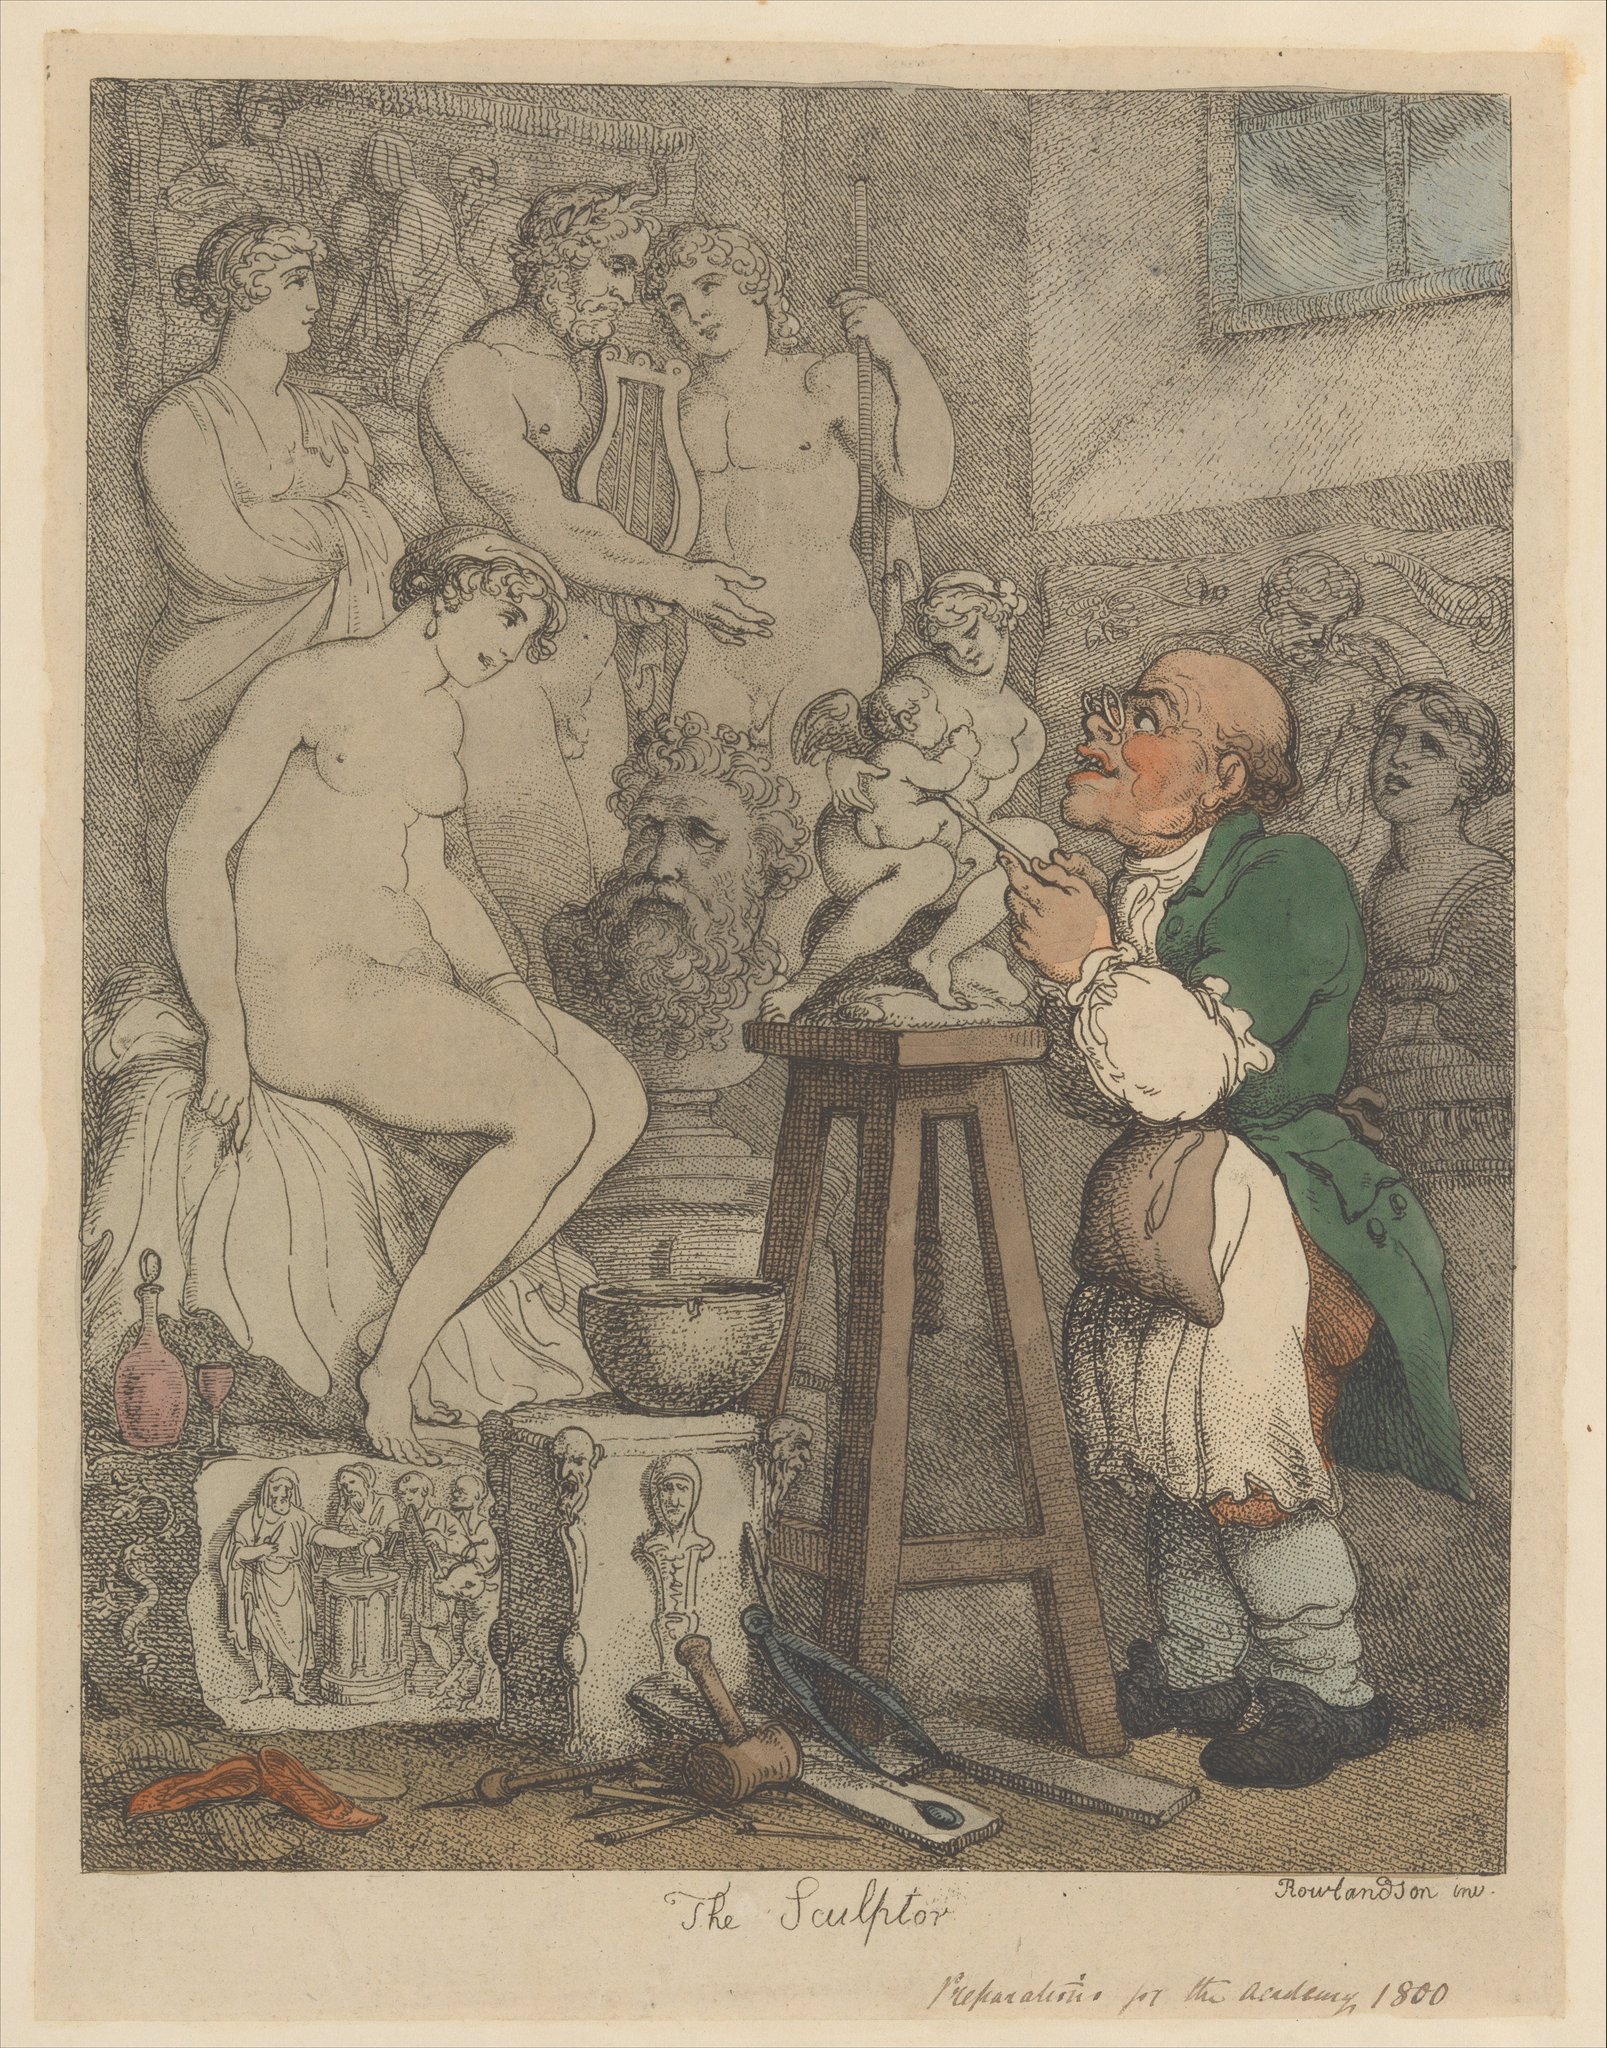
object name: print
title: The Sculptor [Preparations for the Academy, Old Joseph Nollekens and his Venus]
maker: thomas rowlandson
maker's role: artist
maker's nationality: british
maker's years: 1757-1827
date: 1800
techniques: etching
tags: sculpture,men,male nudes,female nudes